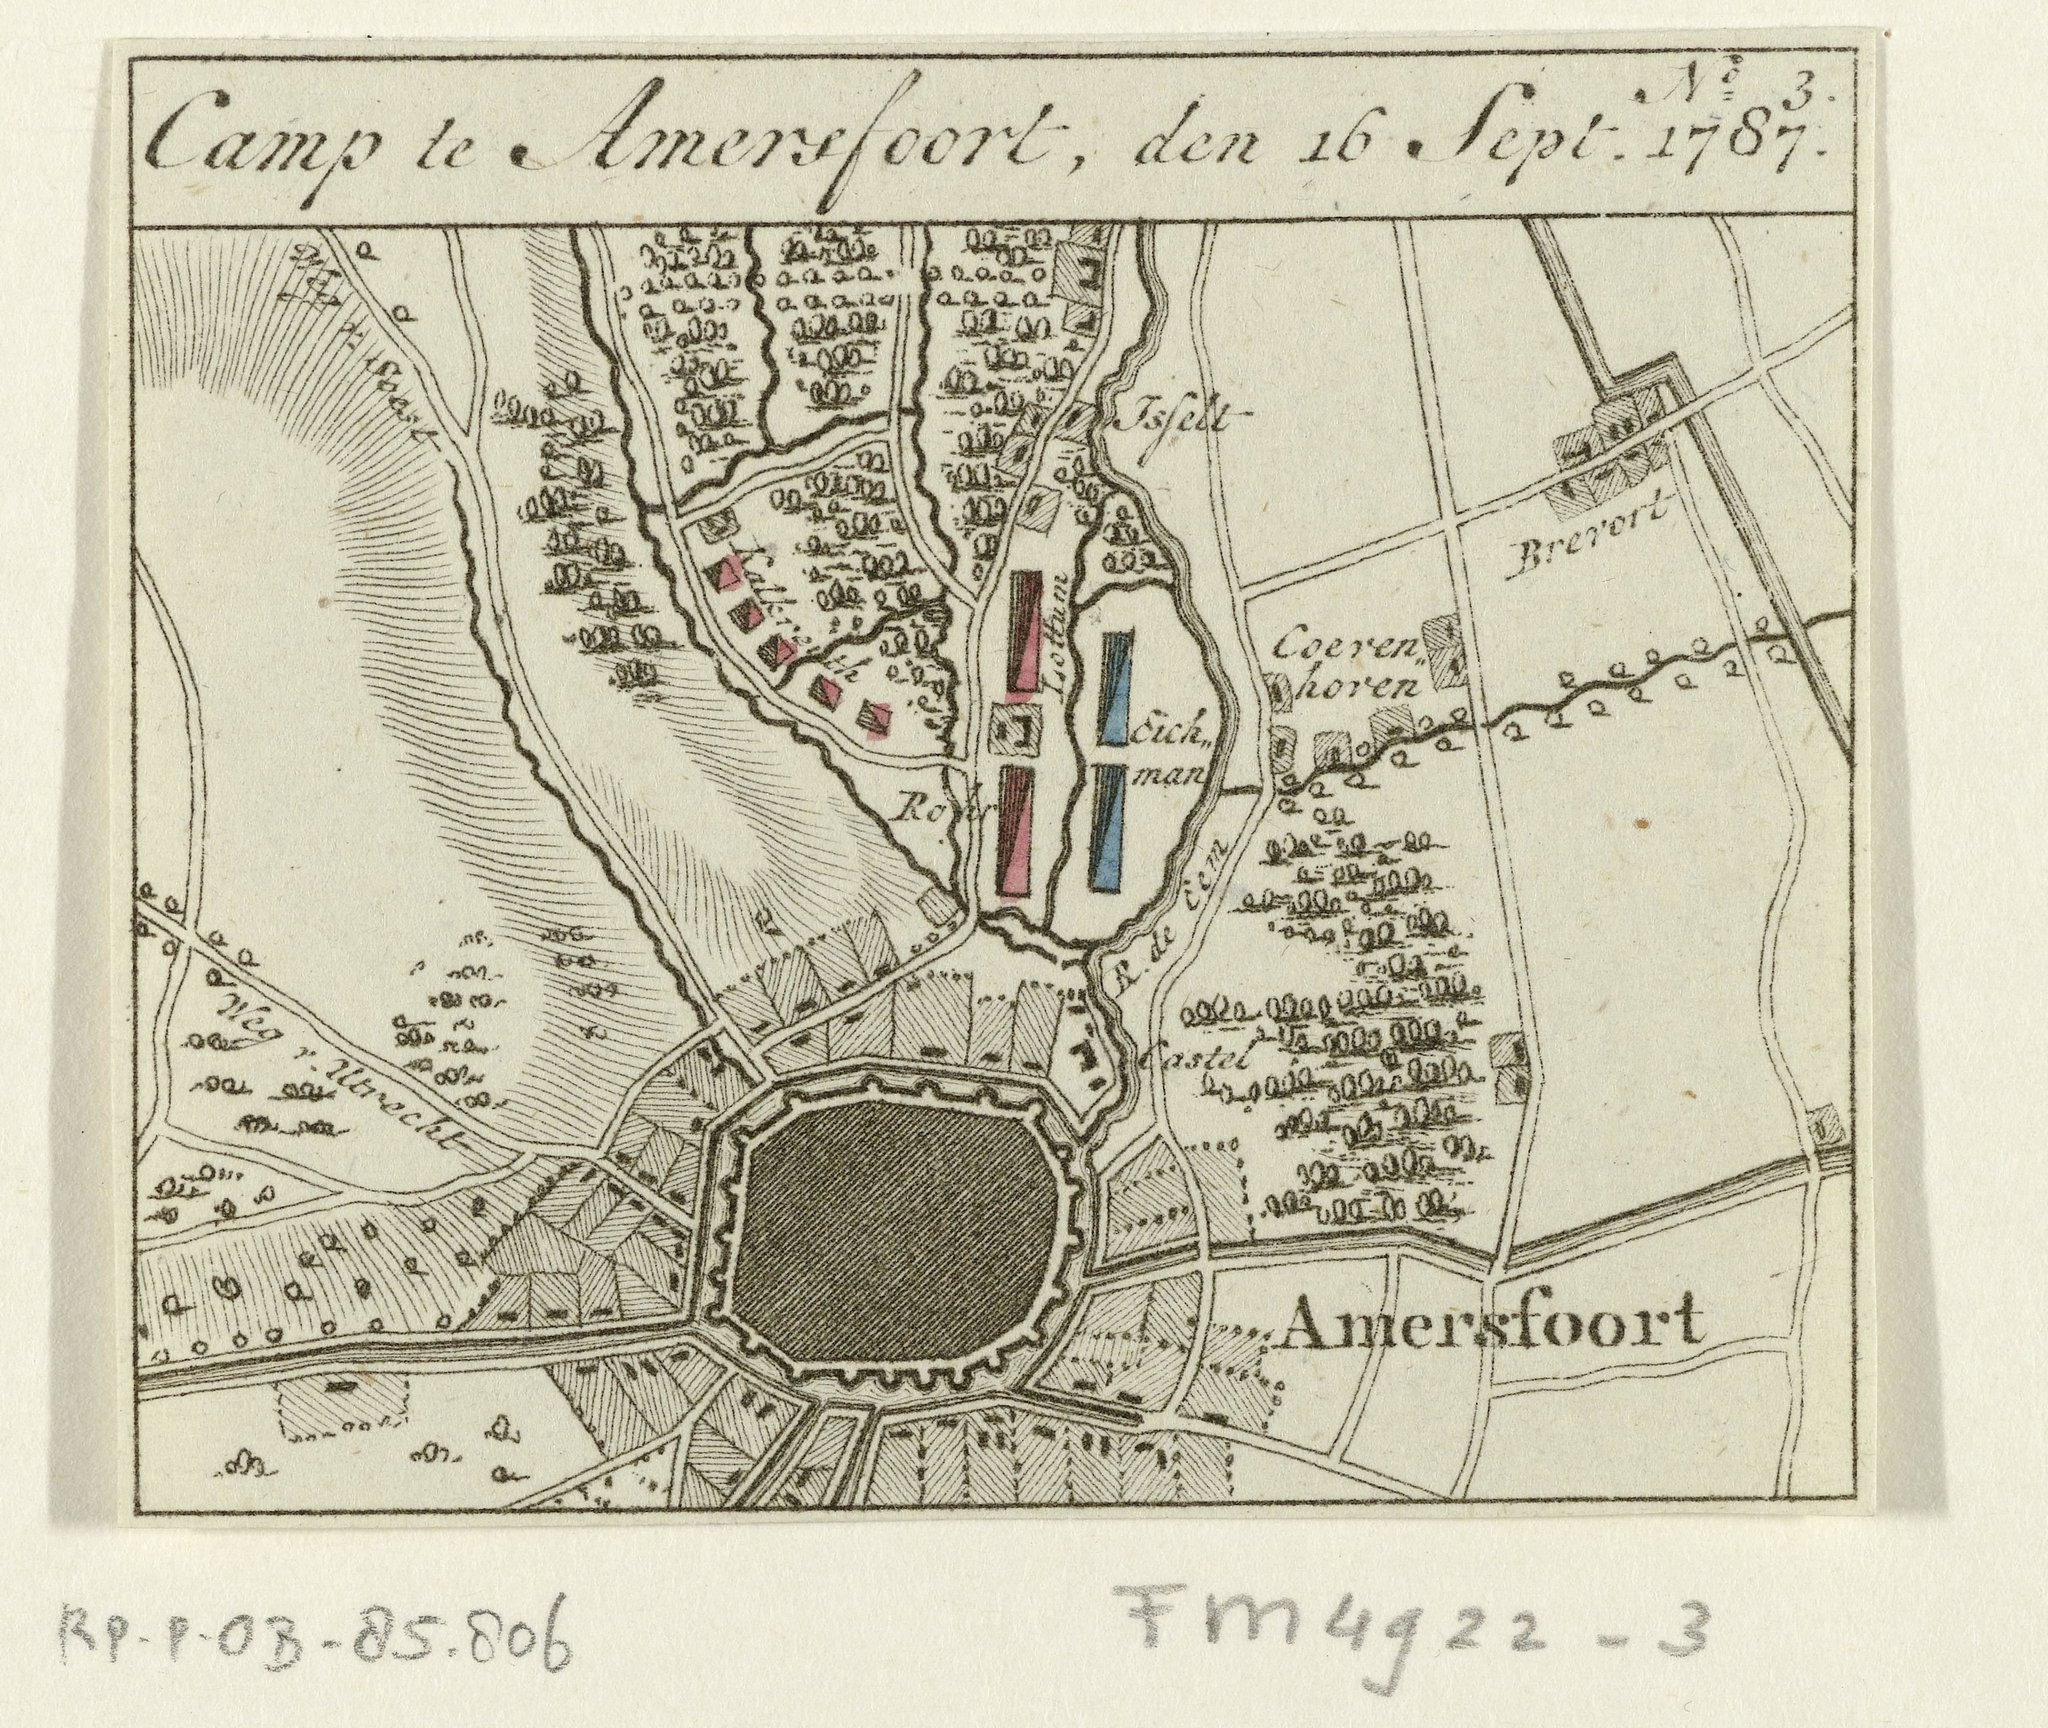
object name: book illustration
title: Kampement van de Pruisen te Amersfoort, 1787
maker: Anonymous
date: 1790-1792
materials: paper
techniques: etching, hand coloring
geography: northern netherlands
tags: maps of cities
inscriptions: collector's mark: Lugt 2228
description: Kaart met de ligging van het kampement van de Pruisische troepen bij Amersfoort op 16 september 1787. Onderdeel van een groep van veertien genummerde kaartjes van de kampementen van de Pruisische troepen tijdens de interventie in de Nederlanden in september 1787.